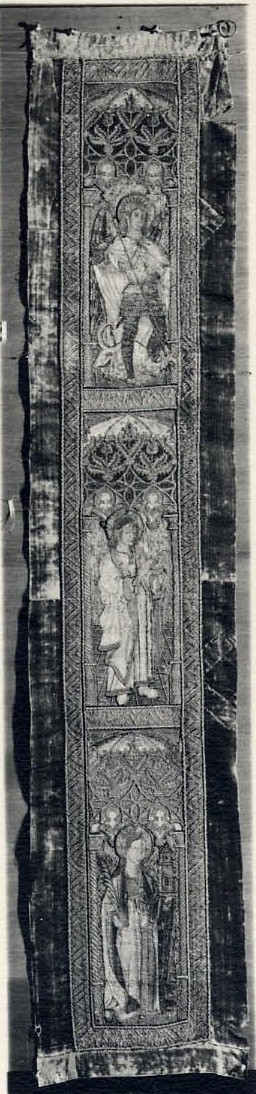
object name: orphrey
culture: italian or spanish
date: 1401-1500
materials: linen, metal thread, silk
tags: human figures